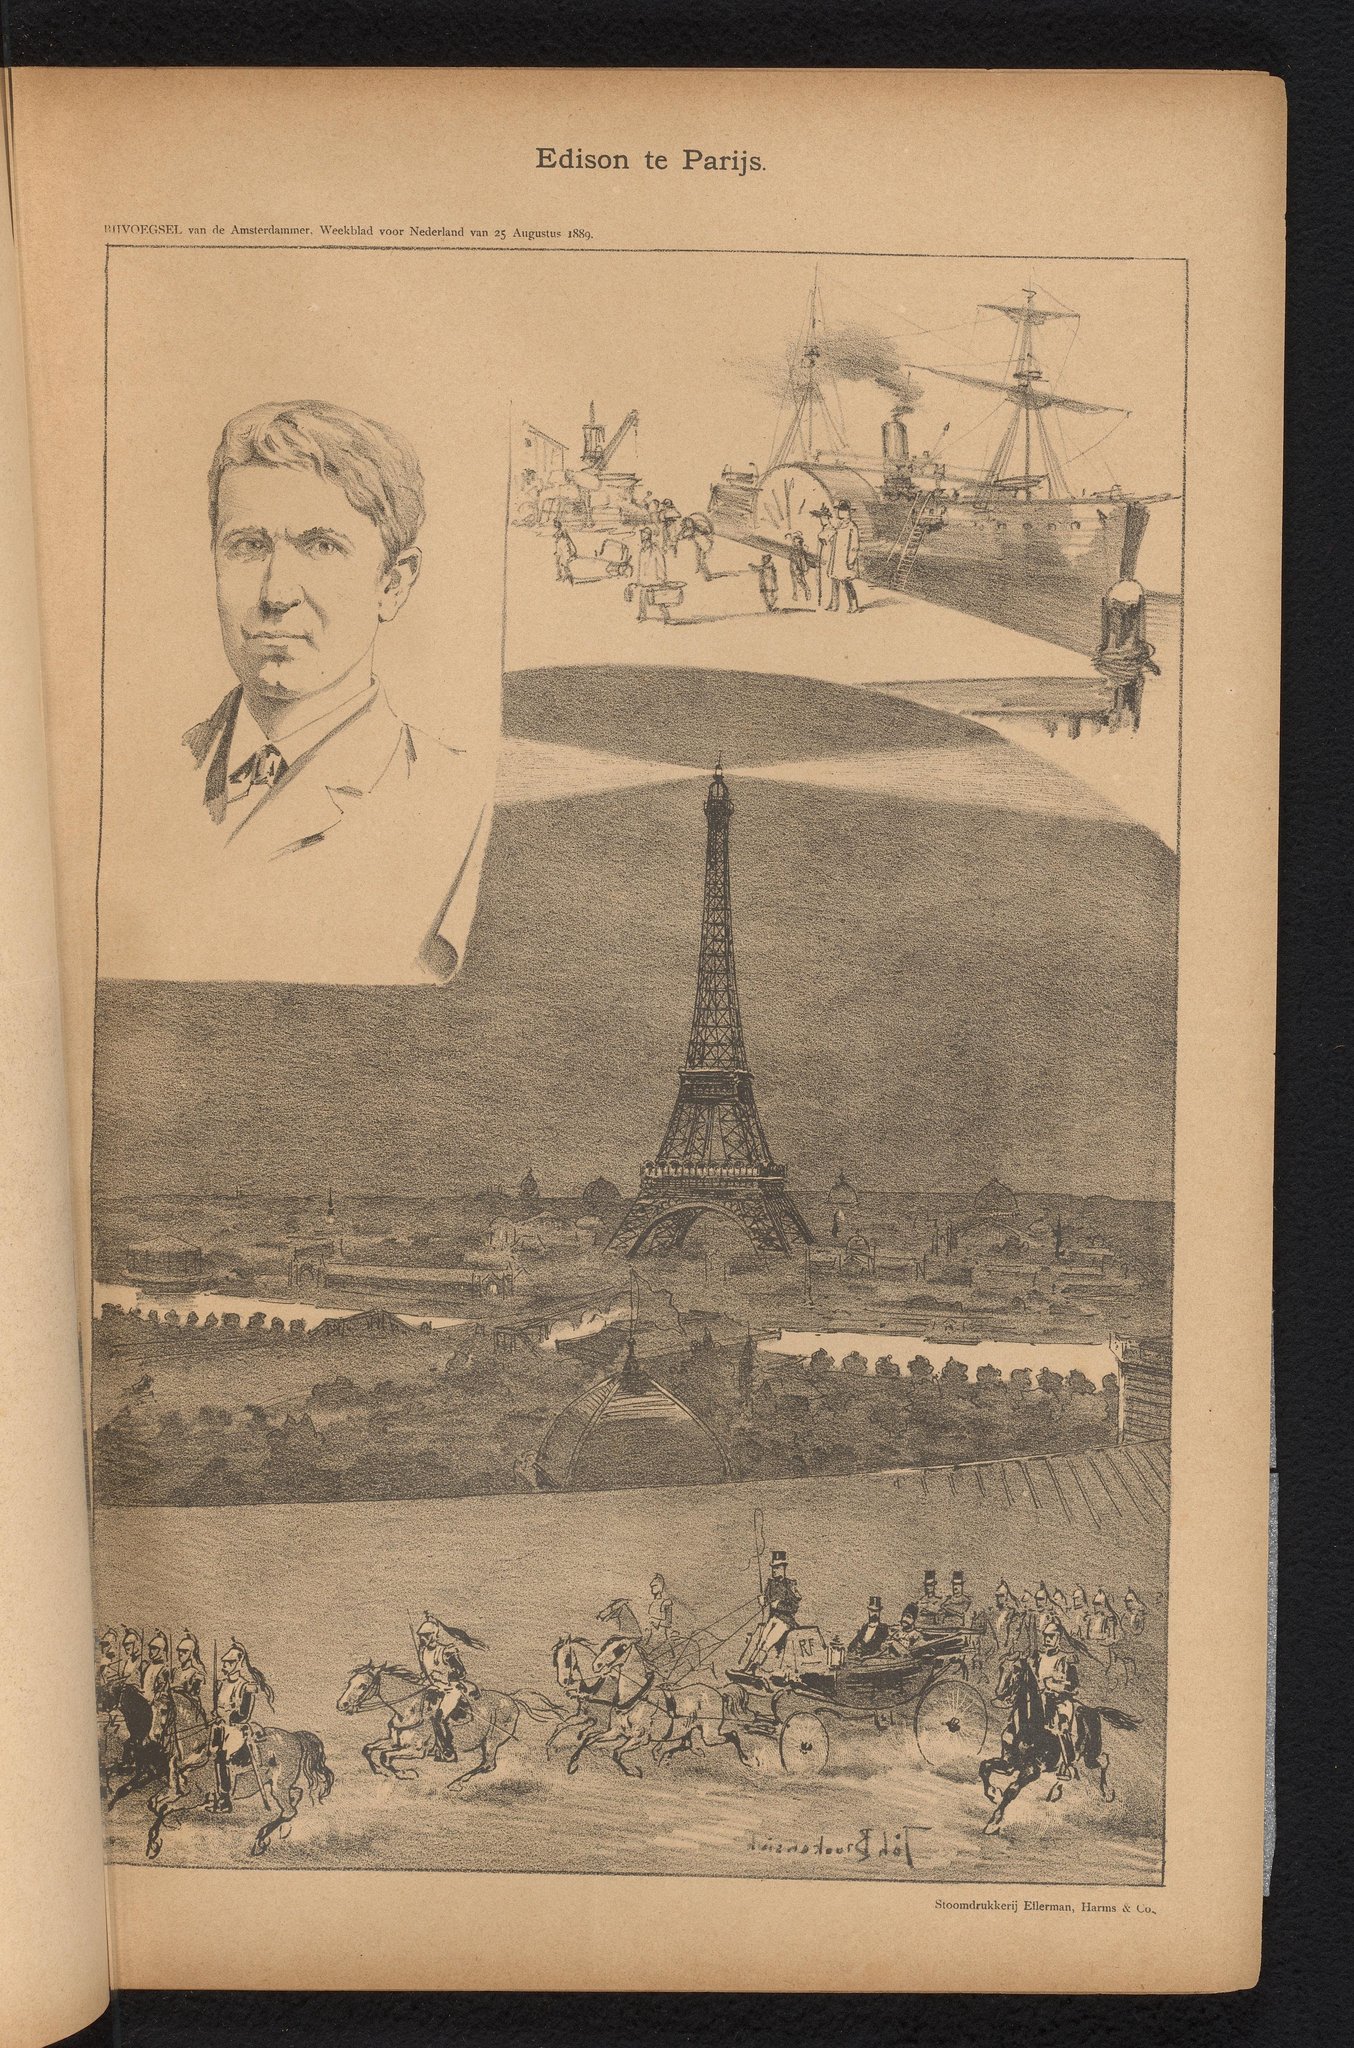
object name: print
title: Edison te Parijs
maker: johan braakensiek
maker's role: draughtsman, print maker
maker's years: 1858-1940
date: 1889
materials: paper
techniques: lithograph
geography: amsterdam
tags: historical persons, political caricatures and satires, paris, eiffel tower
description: Scènes van het bezoek van de Amerikaanse uitvinder Thomas Edison aan Parijs. Centraal de Eiffeltoren.